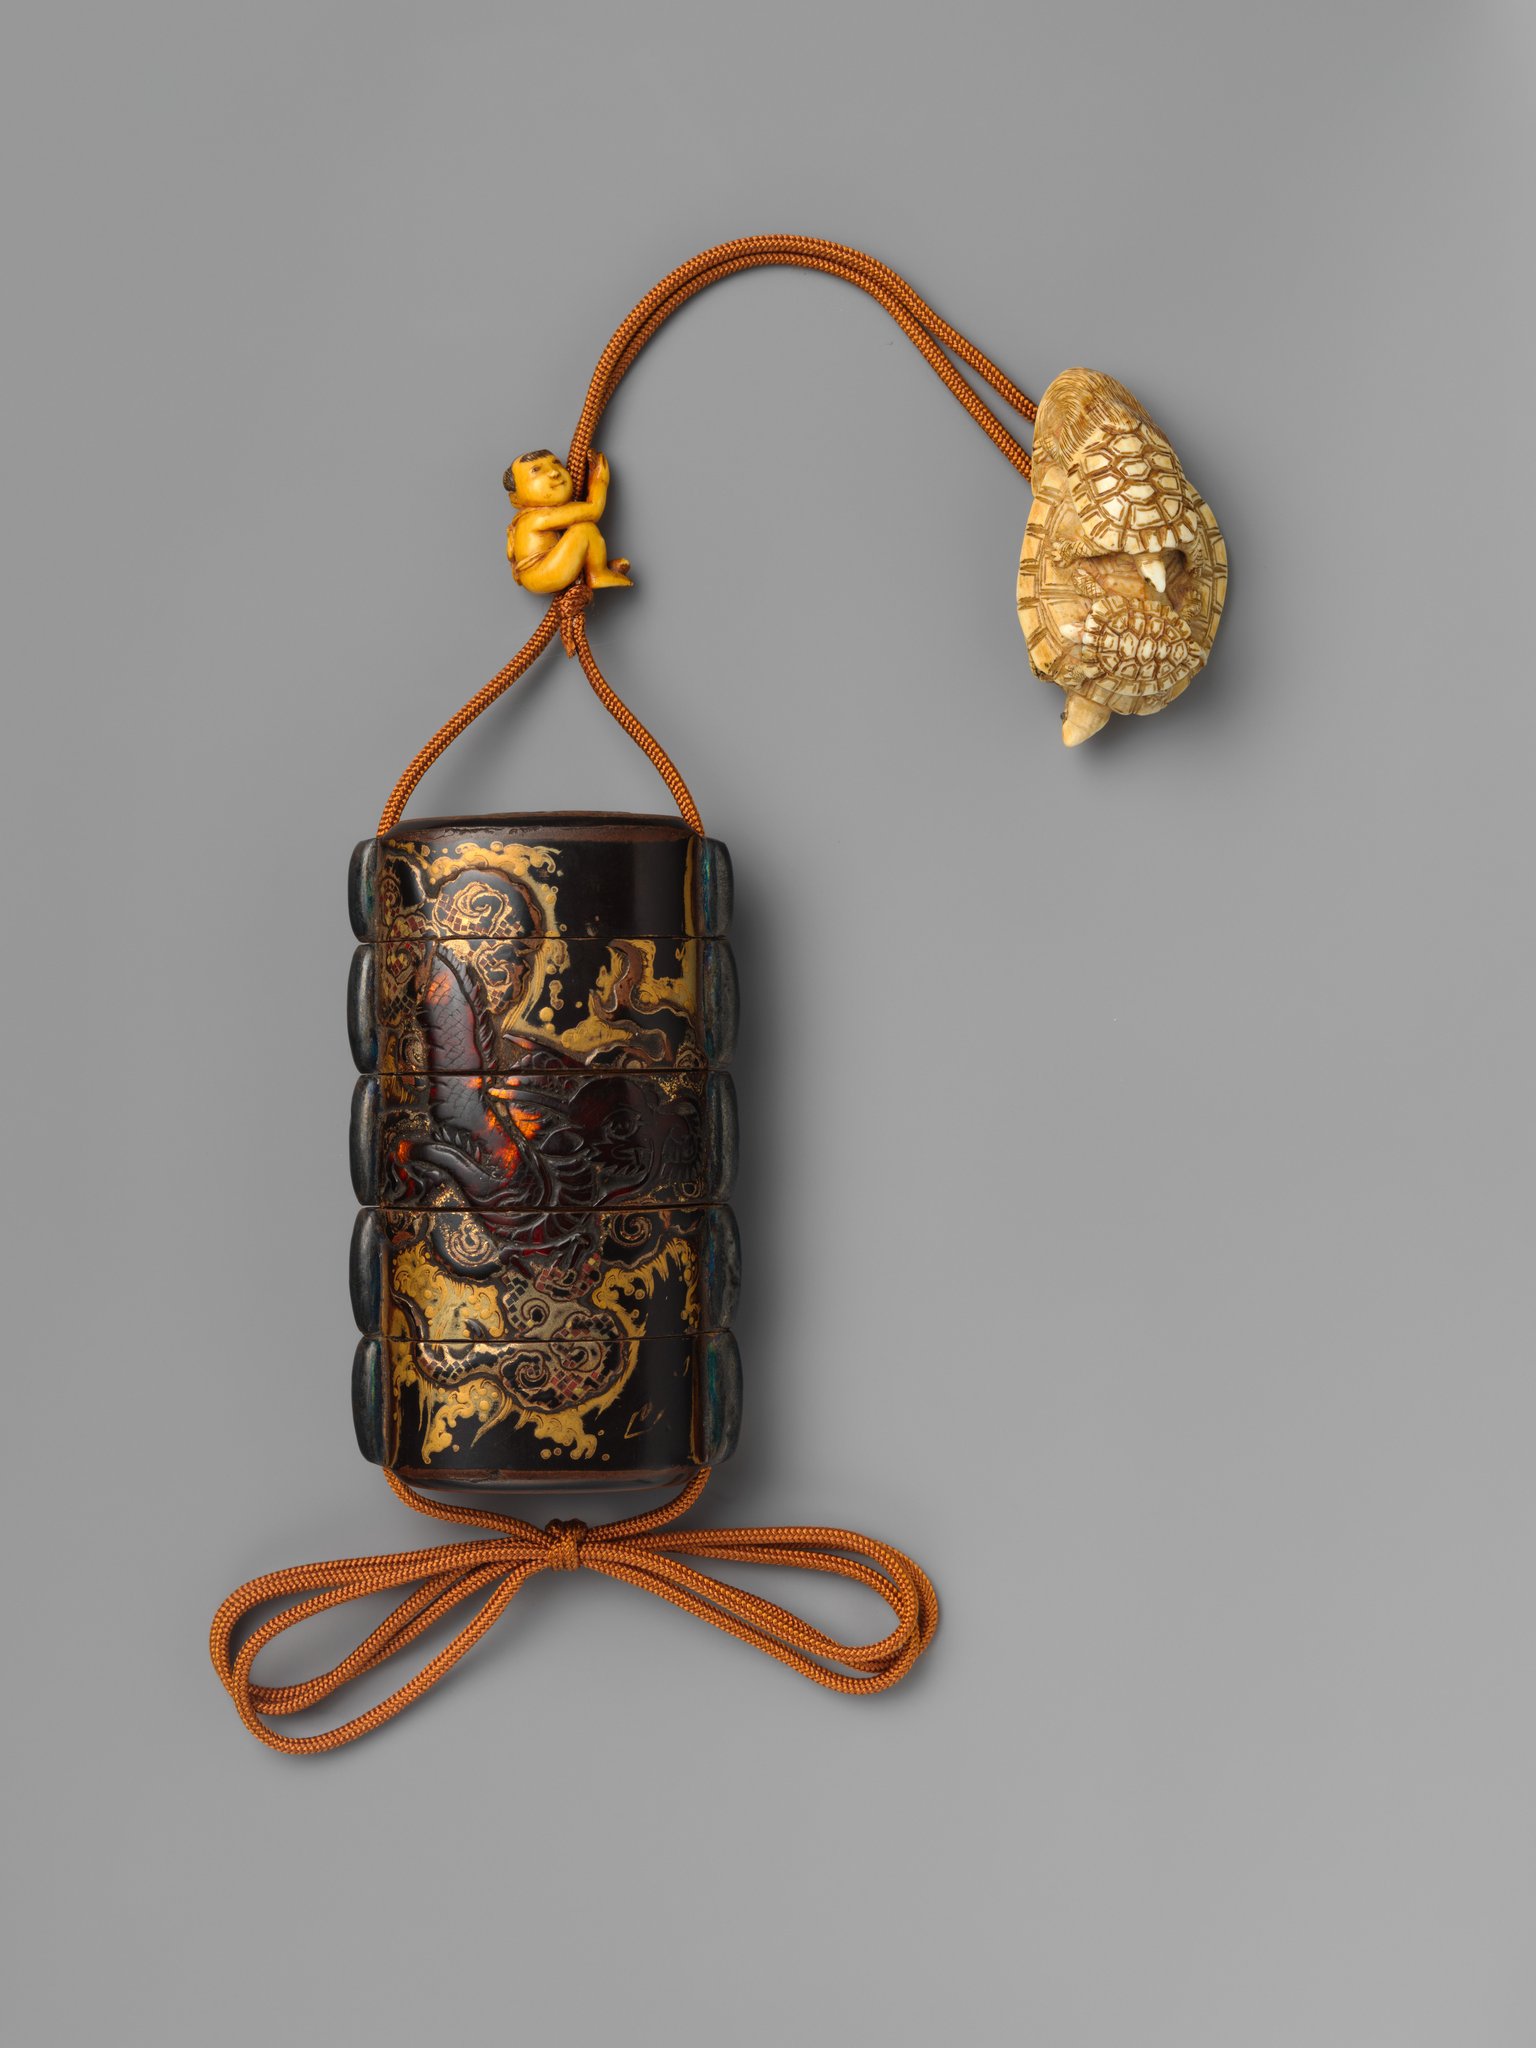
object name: inrō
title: Inrō with Dragon among Clouds and Waves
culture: japanese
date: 1601-1800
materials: cord, gold, gold foil, ivory, lacquer, metal, silver, shell, wood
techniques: carving, hiramakie, inlay, lacquer, maki-e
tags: dragons,waves,clouds